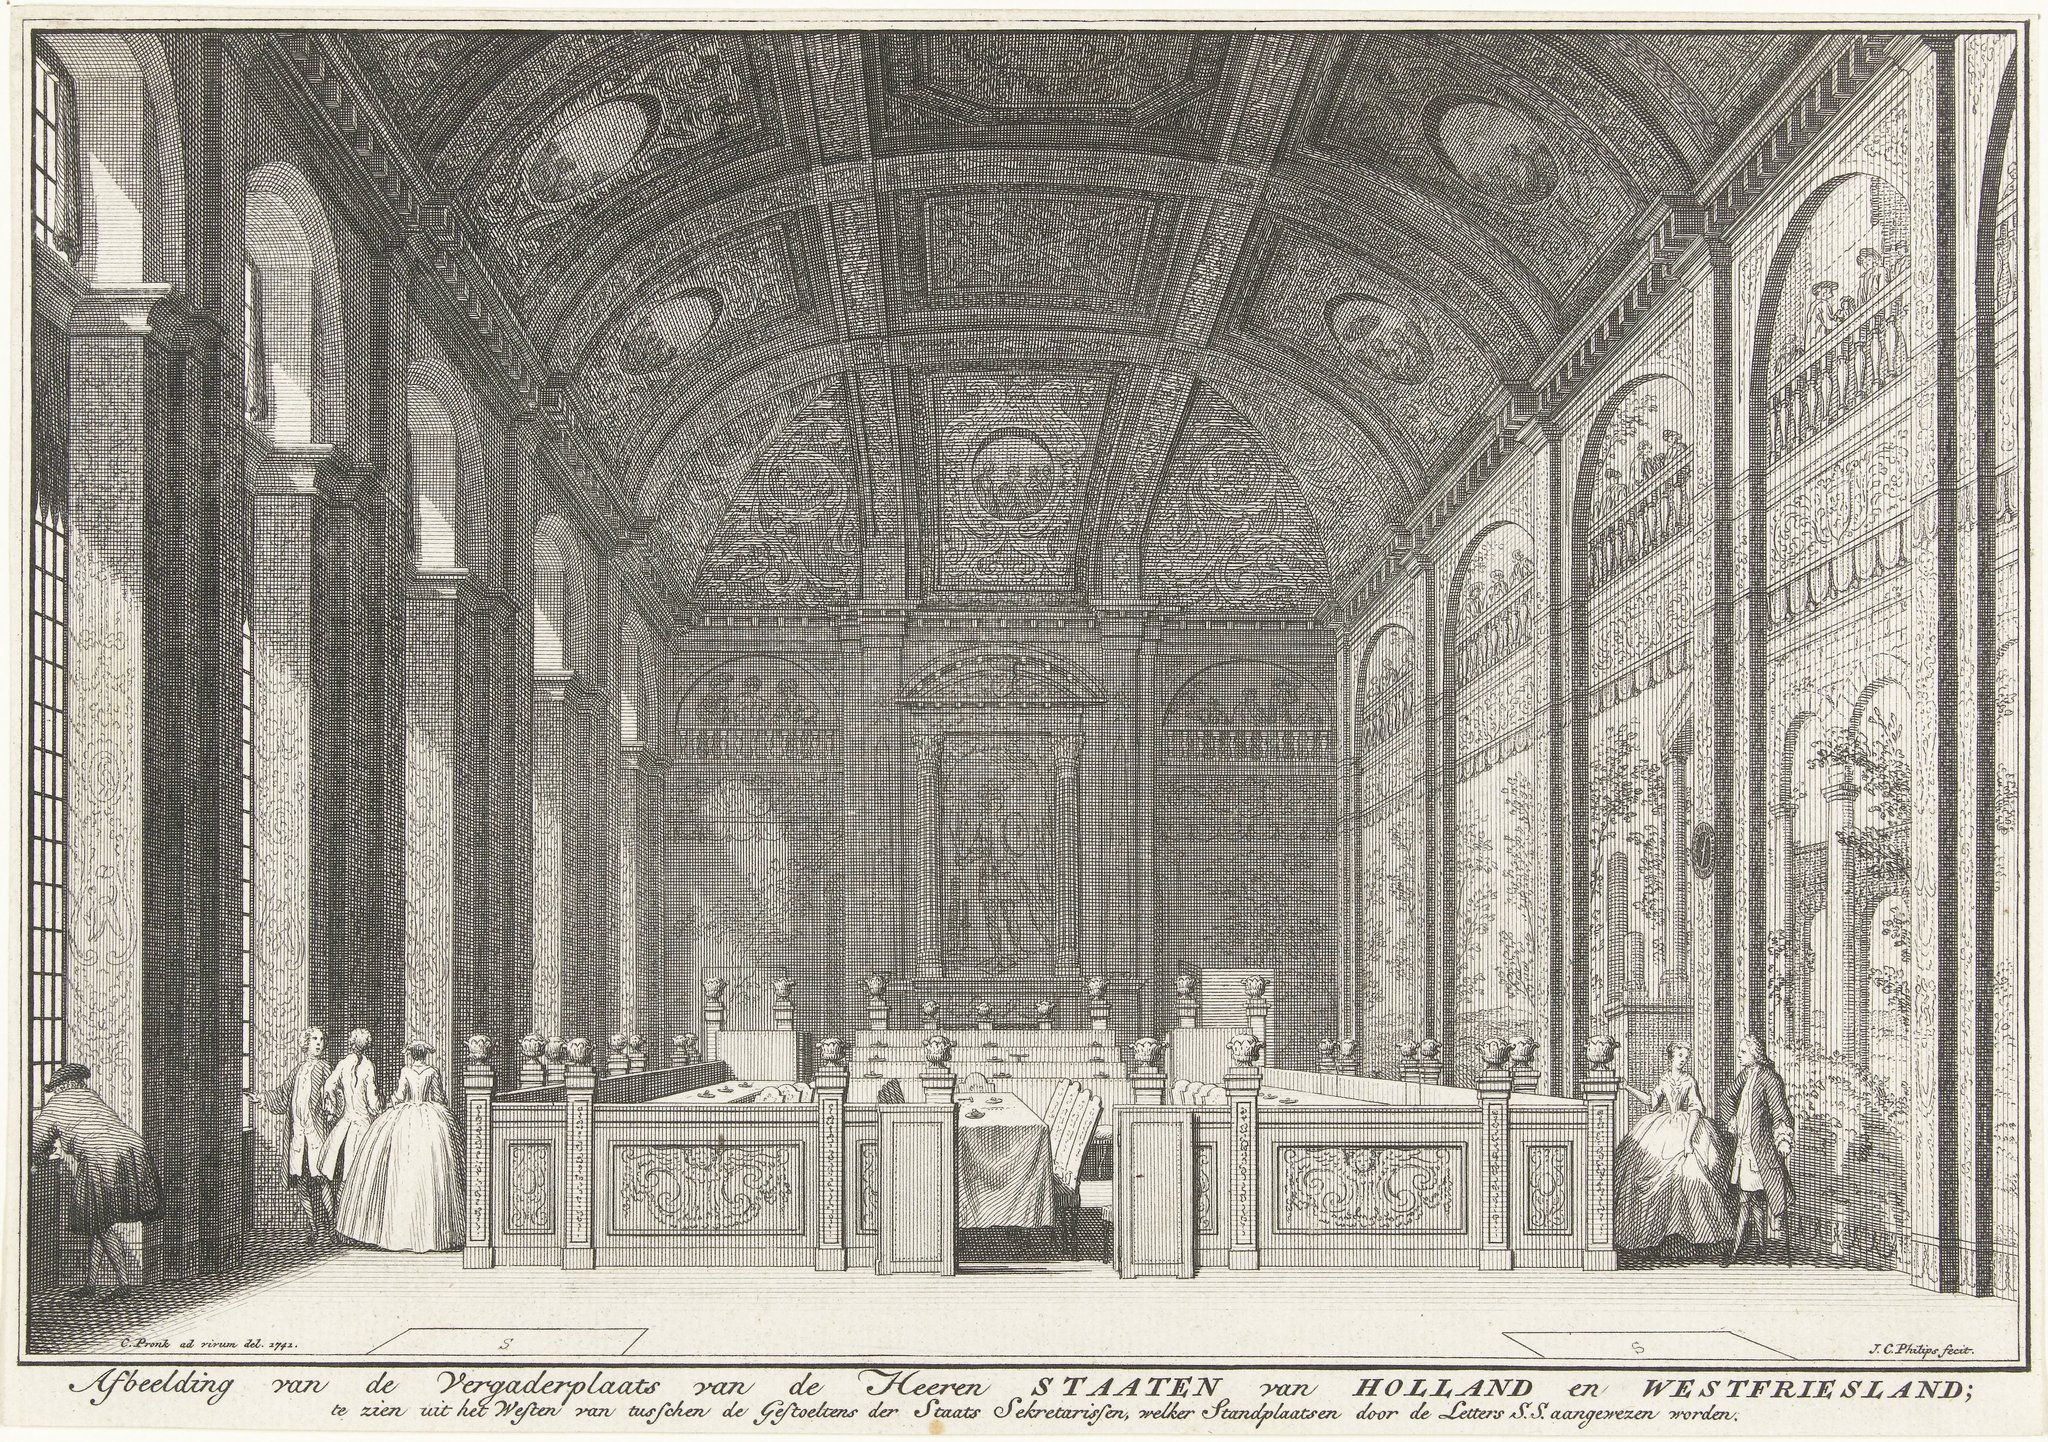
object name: print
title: Vergaderzaal van de Staten van Holland en West-Friesland, 1741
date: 1741-1742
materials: paper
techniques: engraving, etching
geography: amsterdam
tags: national government, lower house, parliament, chamber, the hague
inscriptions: collector's mark: Lugt 2228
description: De vergaderzaal van de Staten van Holland en West-Friesland in het Hof te Den Haag, 1741.